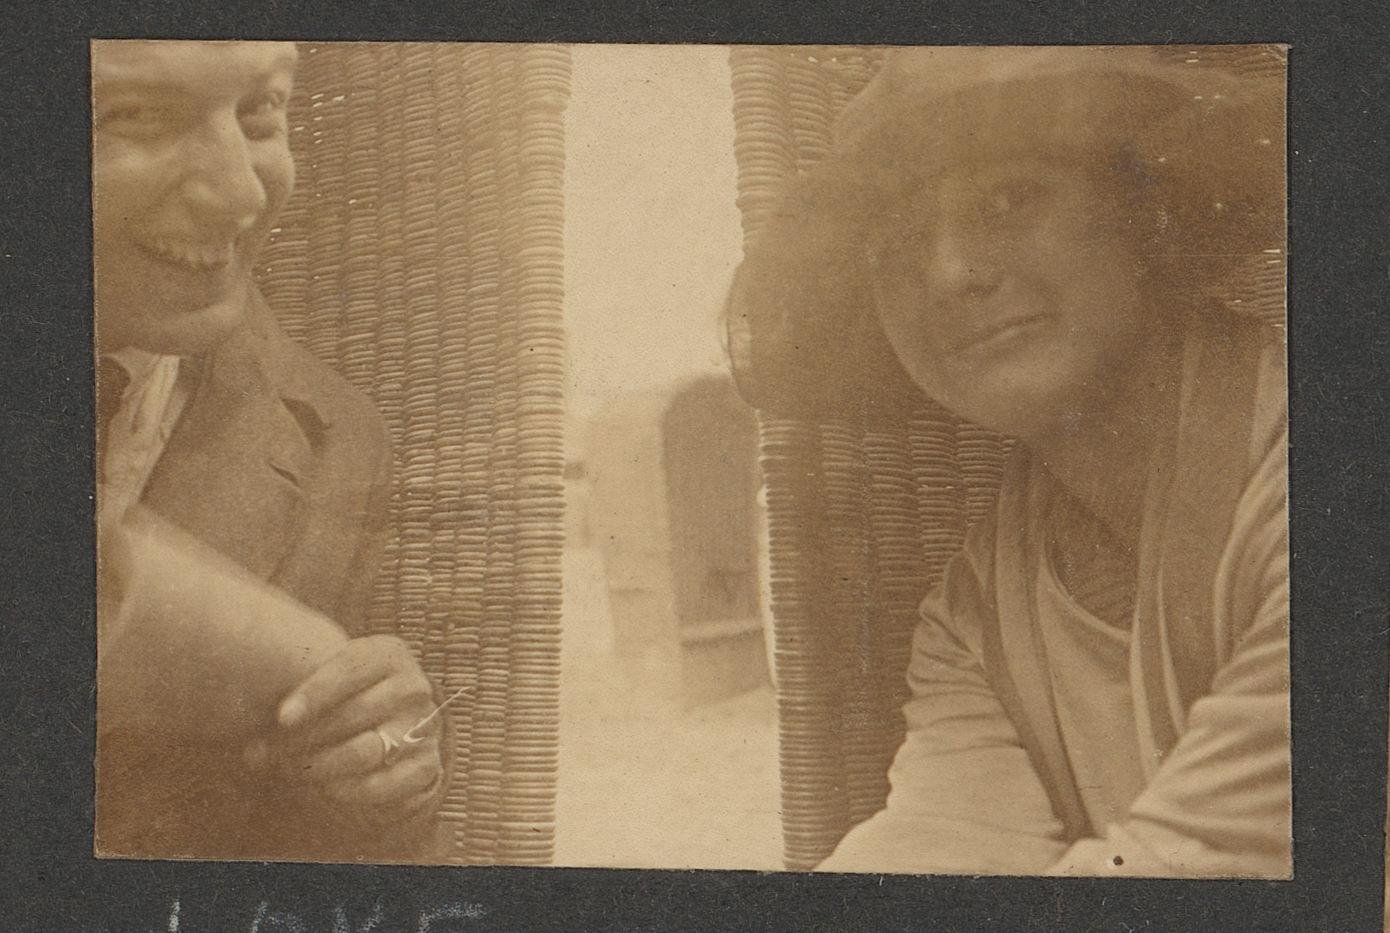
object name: photograph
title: Man en vrouw in strandstoel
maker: Anonymous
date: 1920-1925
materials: paper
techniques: gelatin silver print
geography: south holland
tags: adult woman, adult man, chair, beach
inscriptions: inscription: ‘In the bathchair quadrangle’